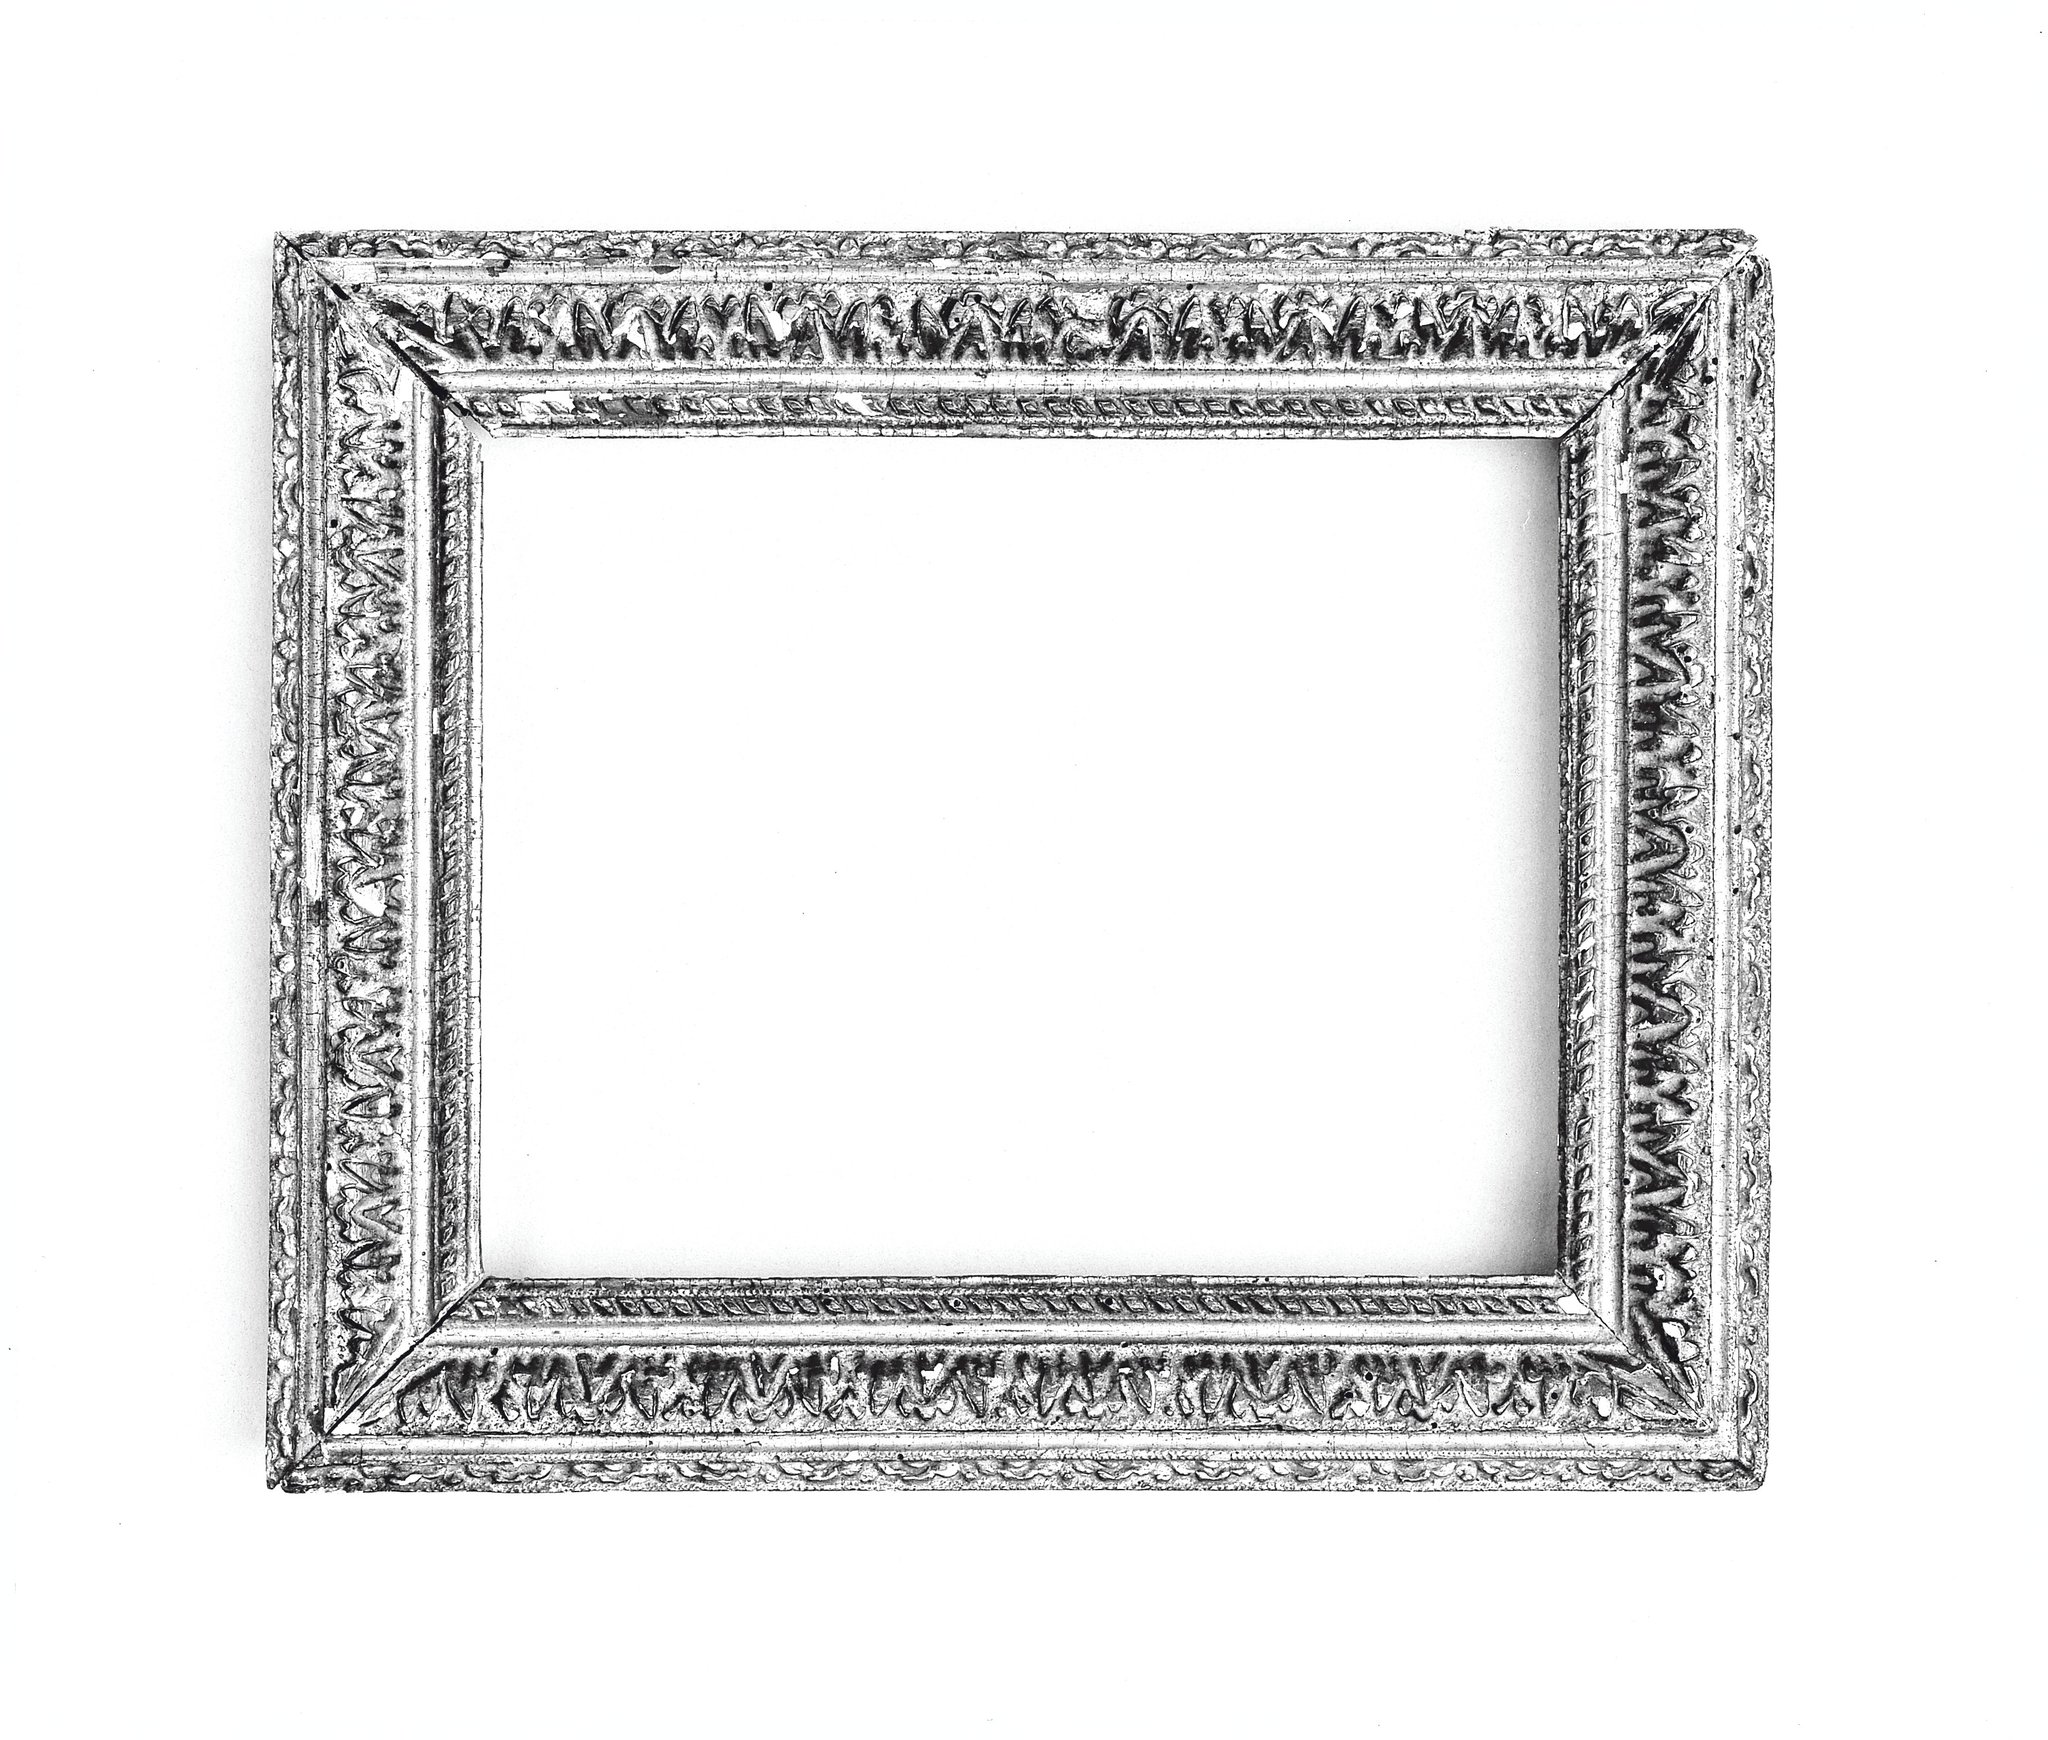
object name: frame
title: Ovolo frame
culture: french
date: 1640-1650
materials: wood